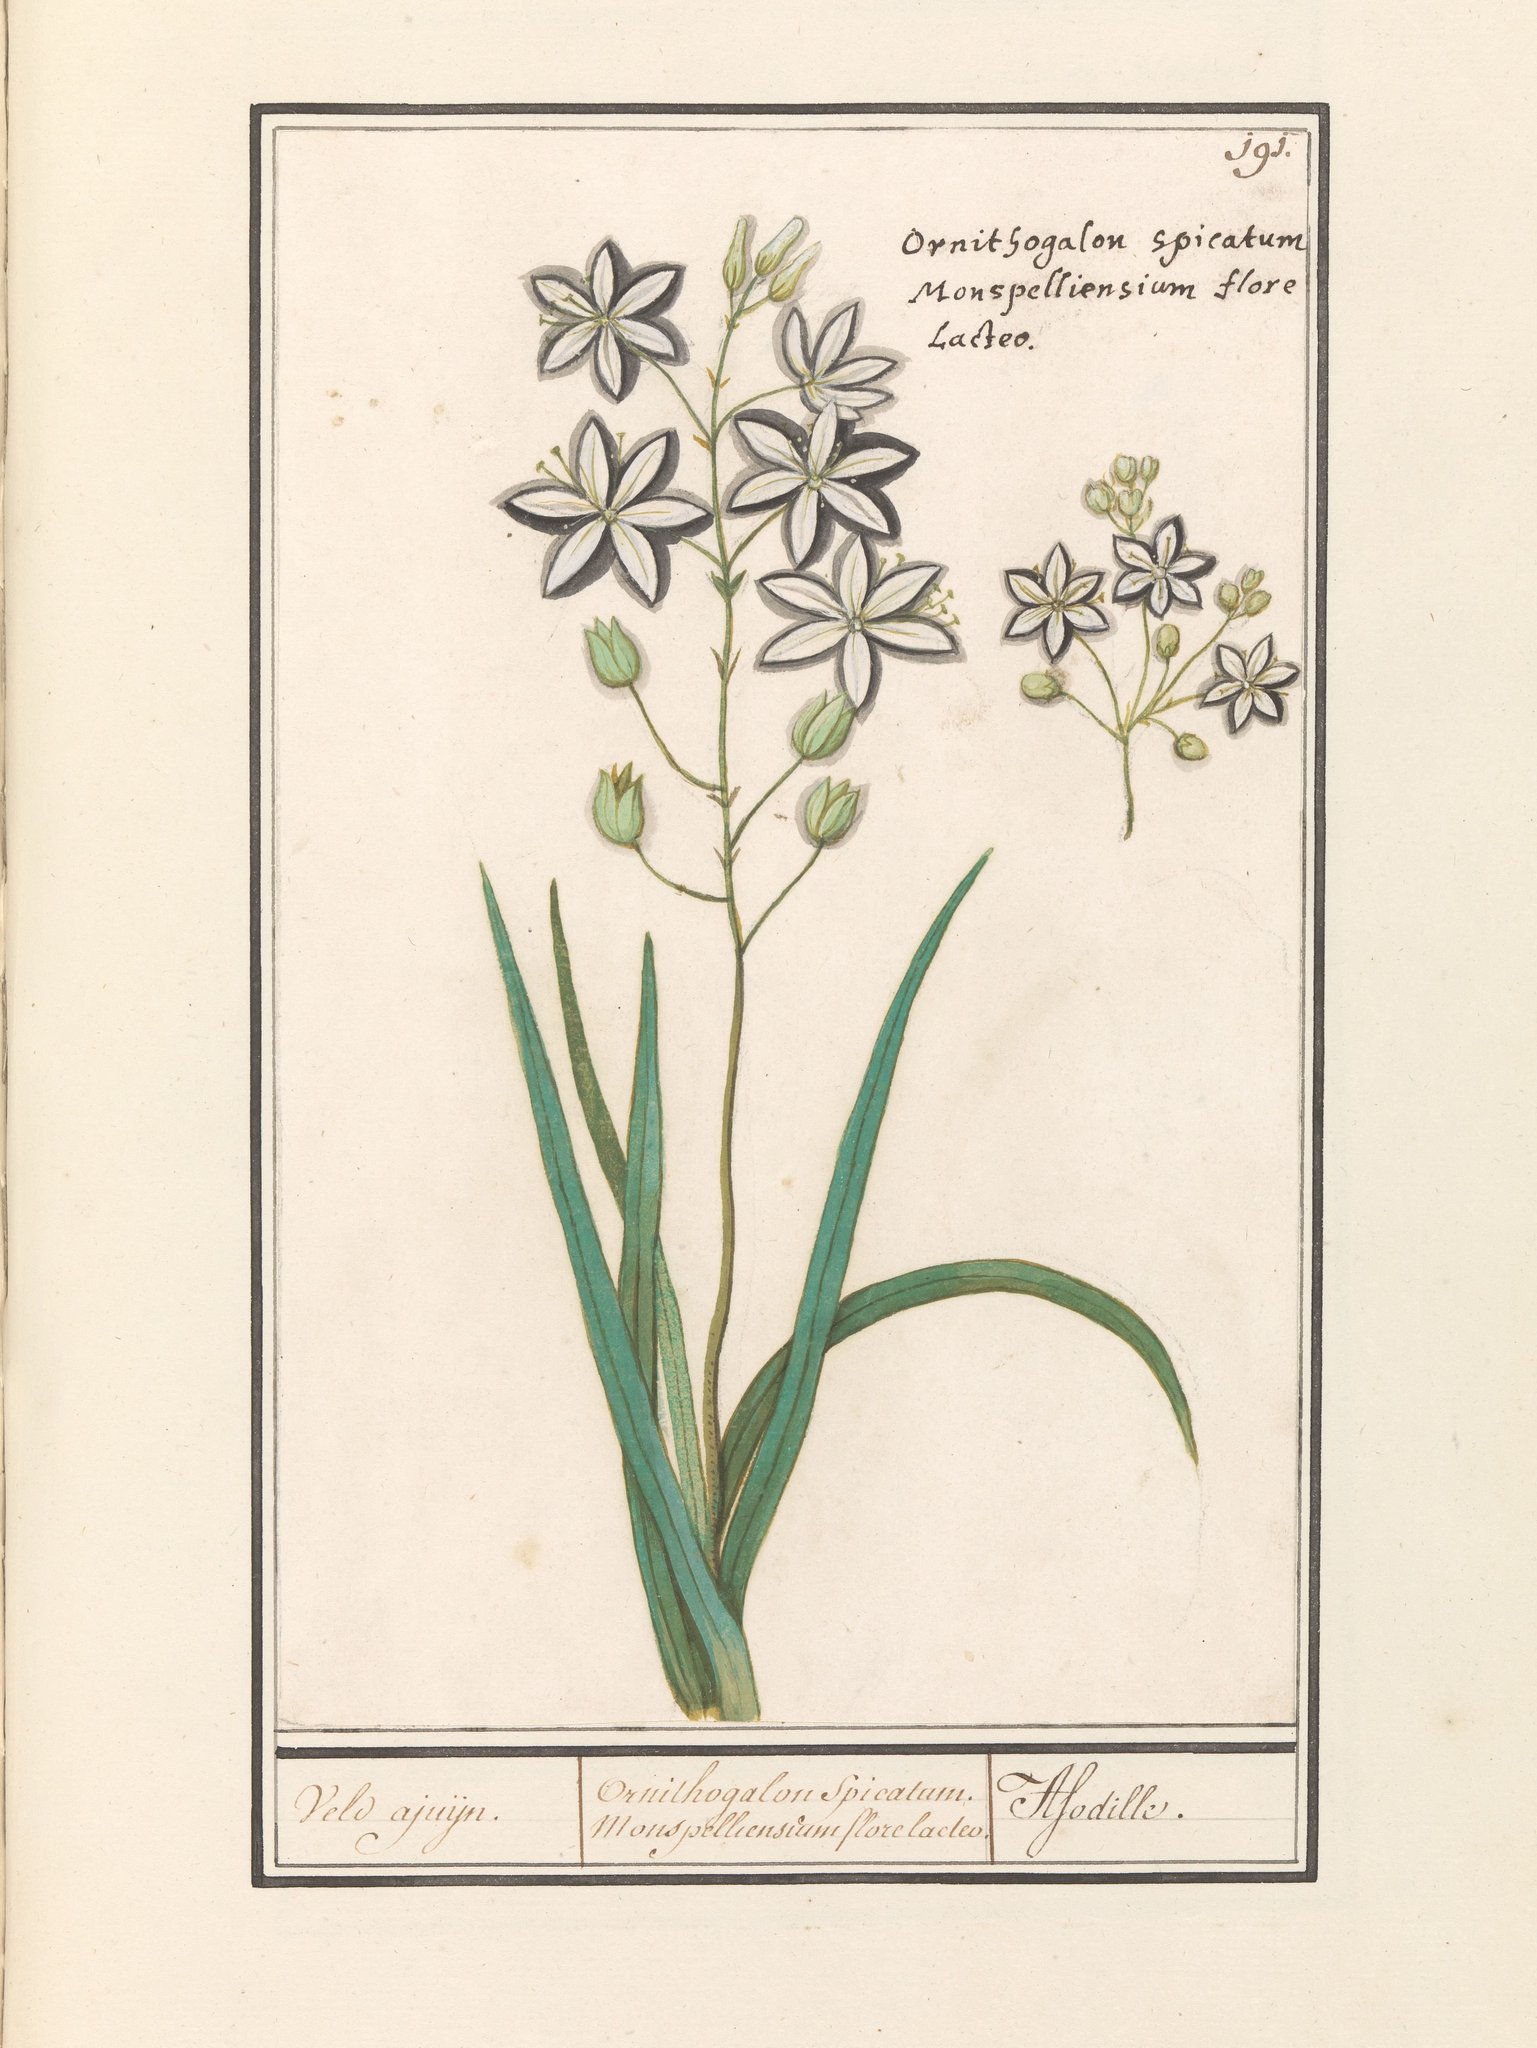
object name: drawing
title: Veld ajuijn. / Ornithogalon Spicatum. Monspelliensium florelacteo. / Afodille.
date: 1596-1610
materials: chalk, paint, ink, paper, watercolor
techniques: brush, pen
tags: flowers: star-of-bethlehem, flowers: asphodelus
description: Affodil of Vogelmelk. Rechtsboven genummerd: 191. Rechtsboven de Latijnse naam. Onderdeel van het tweede album met tekeningen van bloemen en planten. Negende van twaalf albums met tekeningen van dieren, vogels en planten bekend rond 1600, gemaakt in opdracht van keizer Rudolf II. Met toelichting in Nederlands, Latijn en Frans.